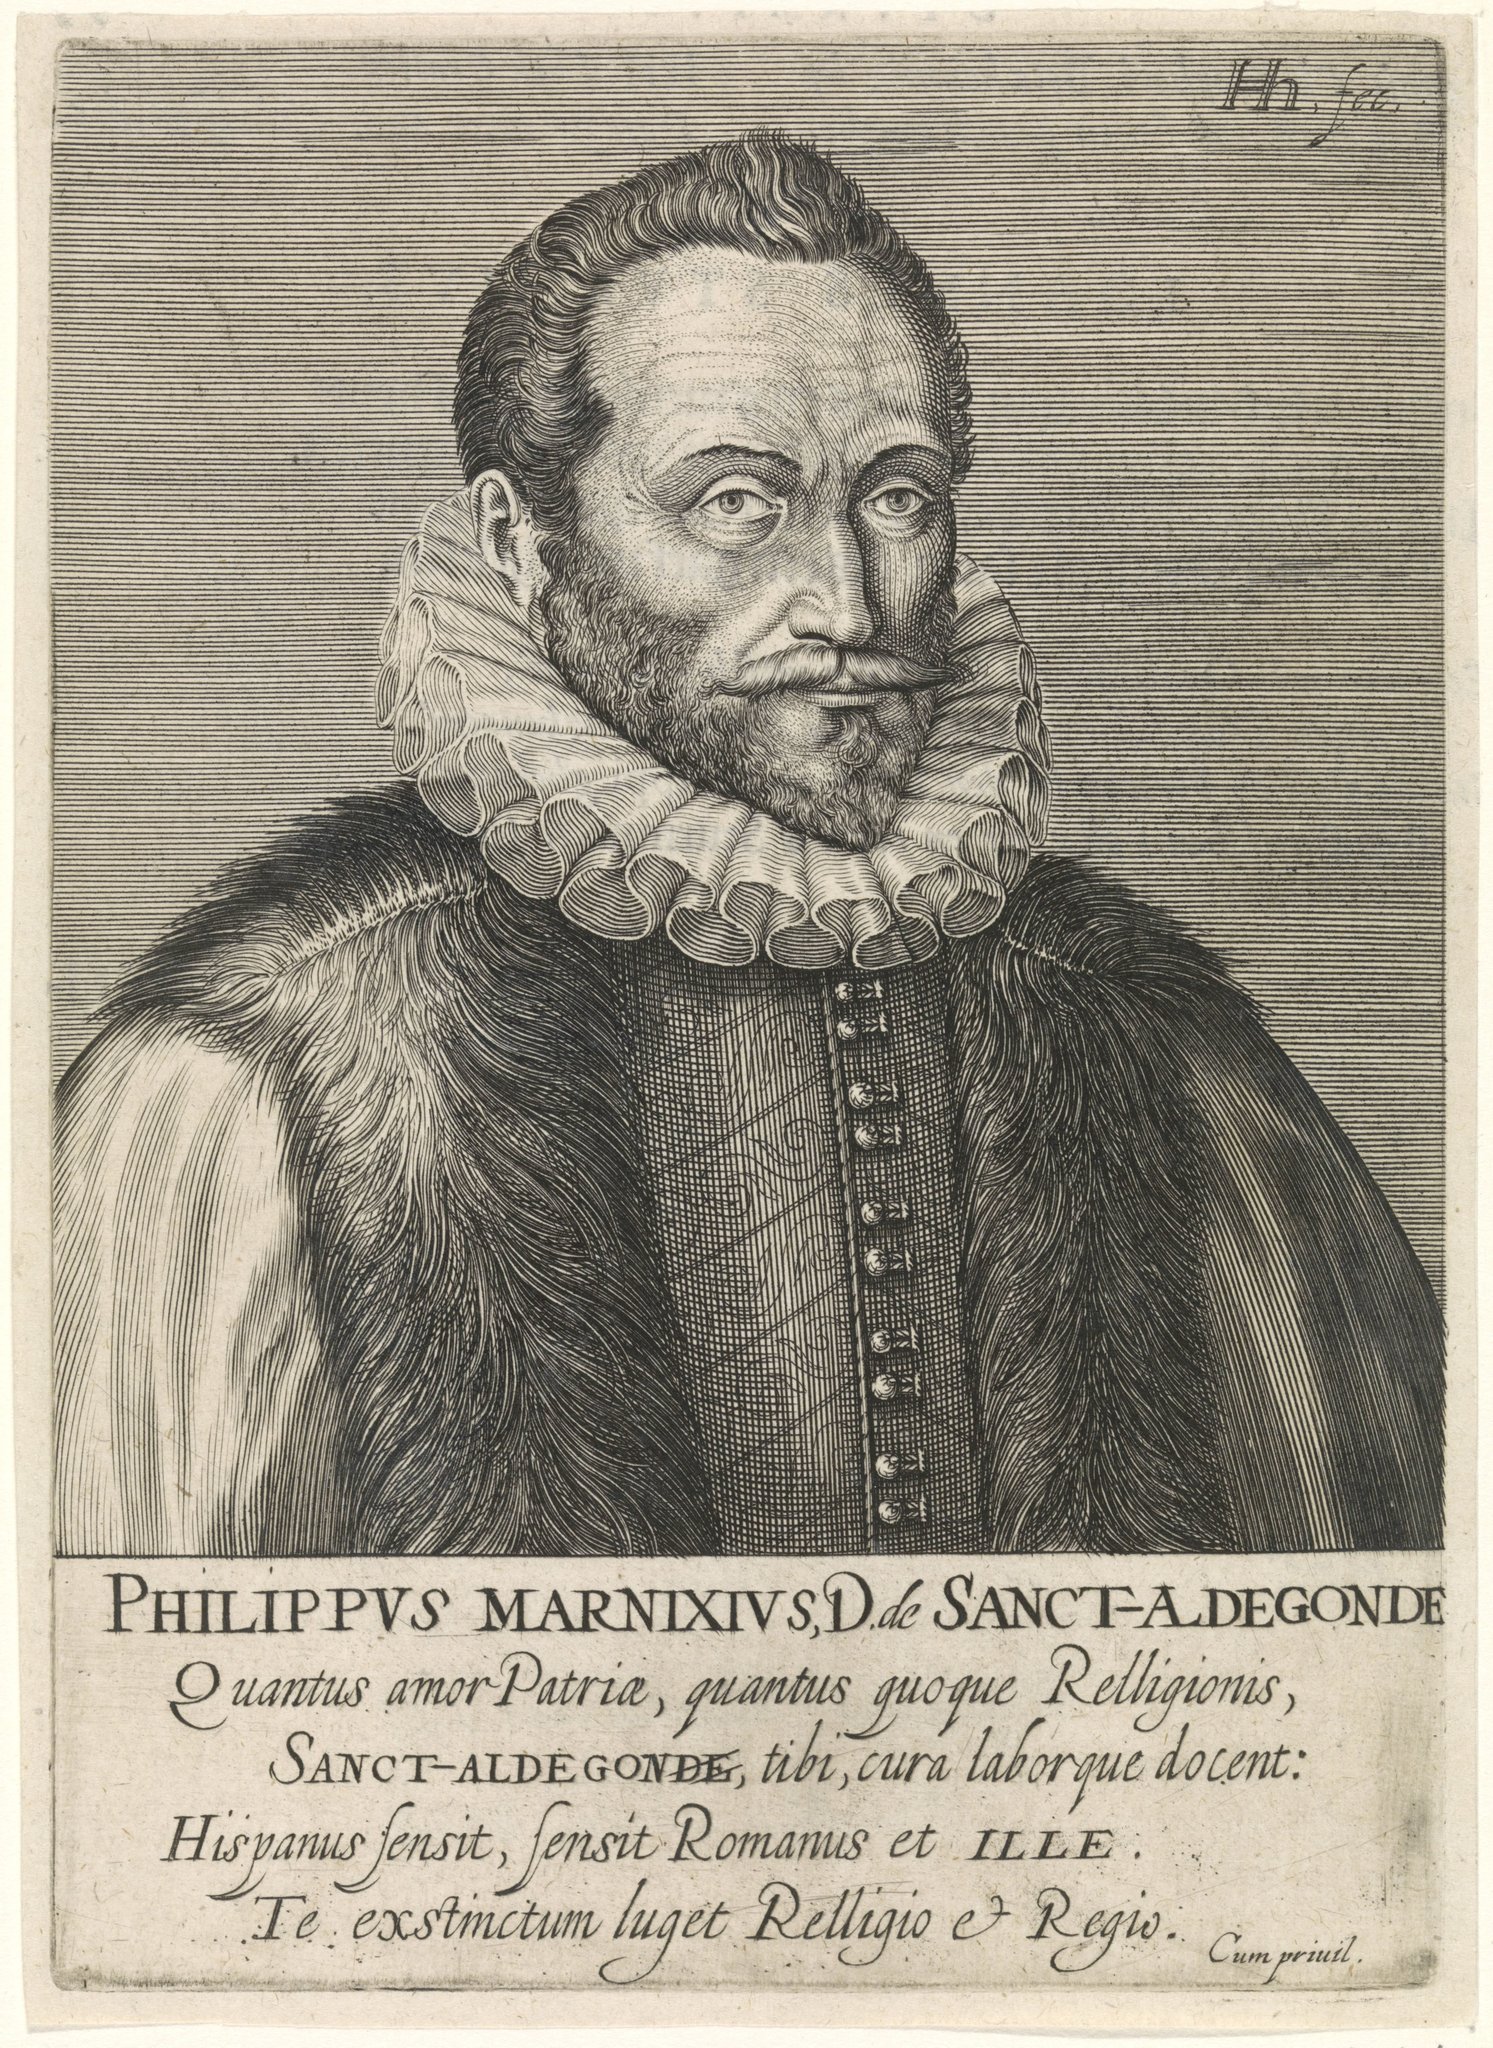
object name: print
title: Beroemde hervormers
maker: hendrick hondius (i)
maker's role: draughtsman, print maker, publisher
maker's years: 1573-1650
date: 1599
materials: paper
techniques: engraving, letterpress printing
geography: the hague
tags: brussels, leiden, politician, filips van marnix van sint-aldegonde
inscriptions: collector's mark: Lugt 2228, collector's mark: Lugt 2760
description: Prent ook gebruikt als boekillustratie in: Jacob Verheiden, Præstantium aliquot theologorum, qui rom. antichristum præcipuè oppugnarunt, effigies. Den Haag: Hendrick Hondius I en Den Haag: B.C. Nieulandt, 1602-1603. Tevens: Arnhem, J.Janssen, 1604.